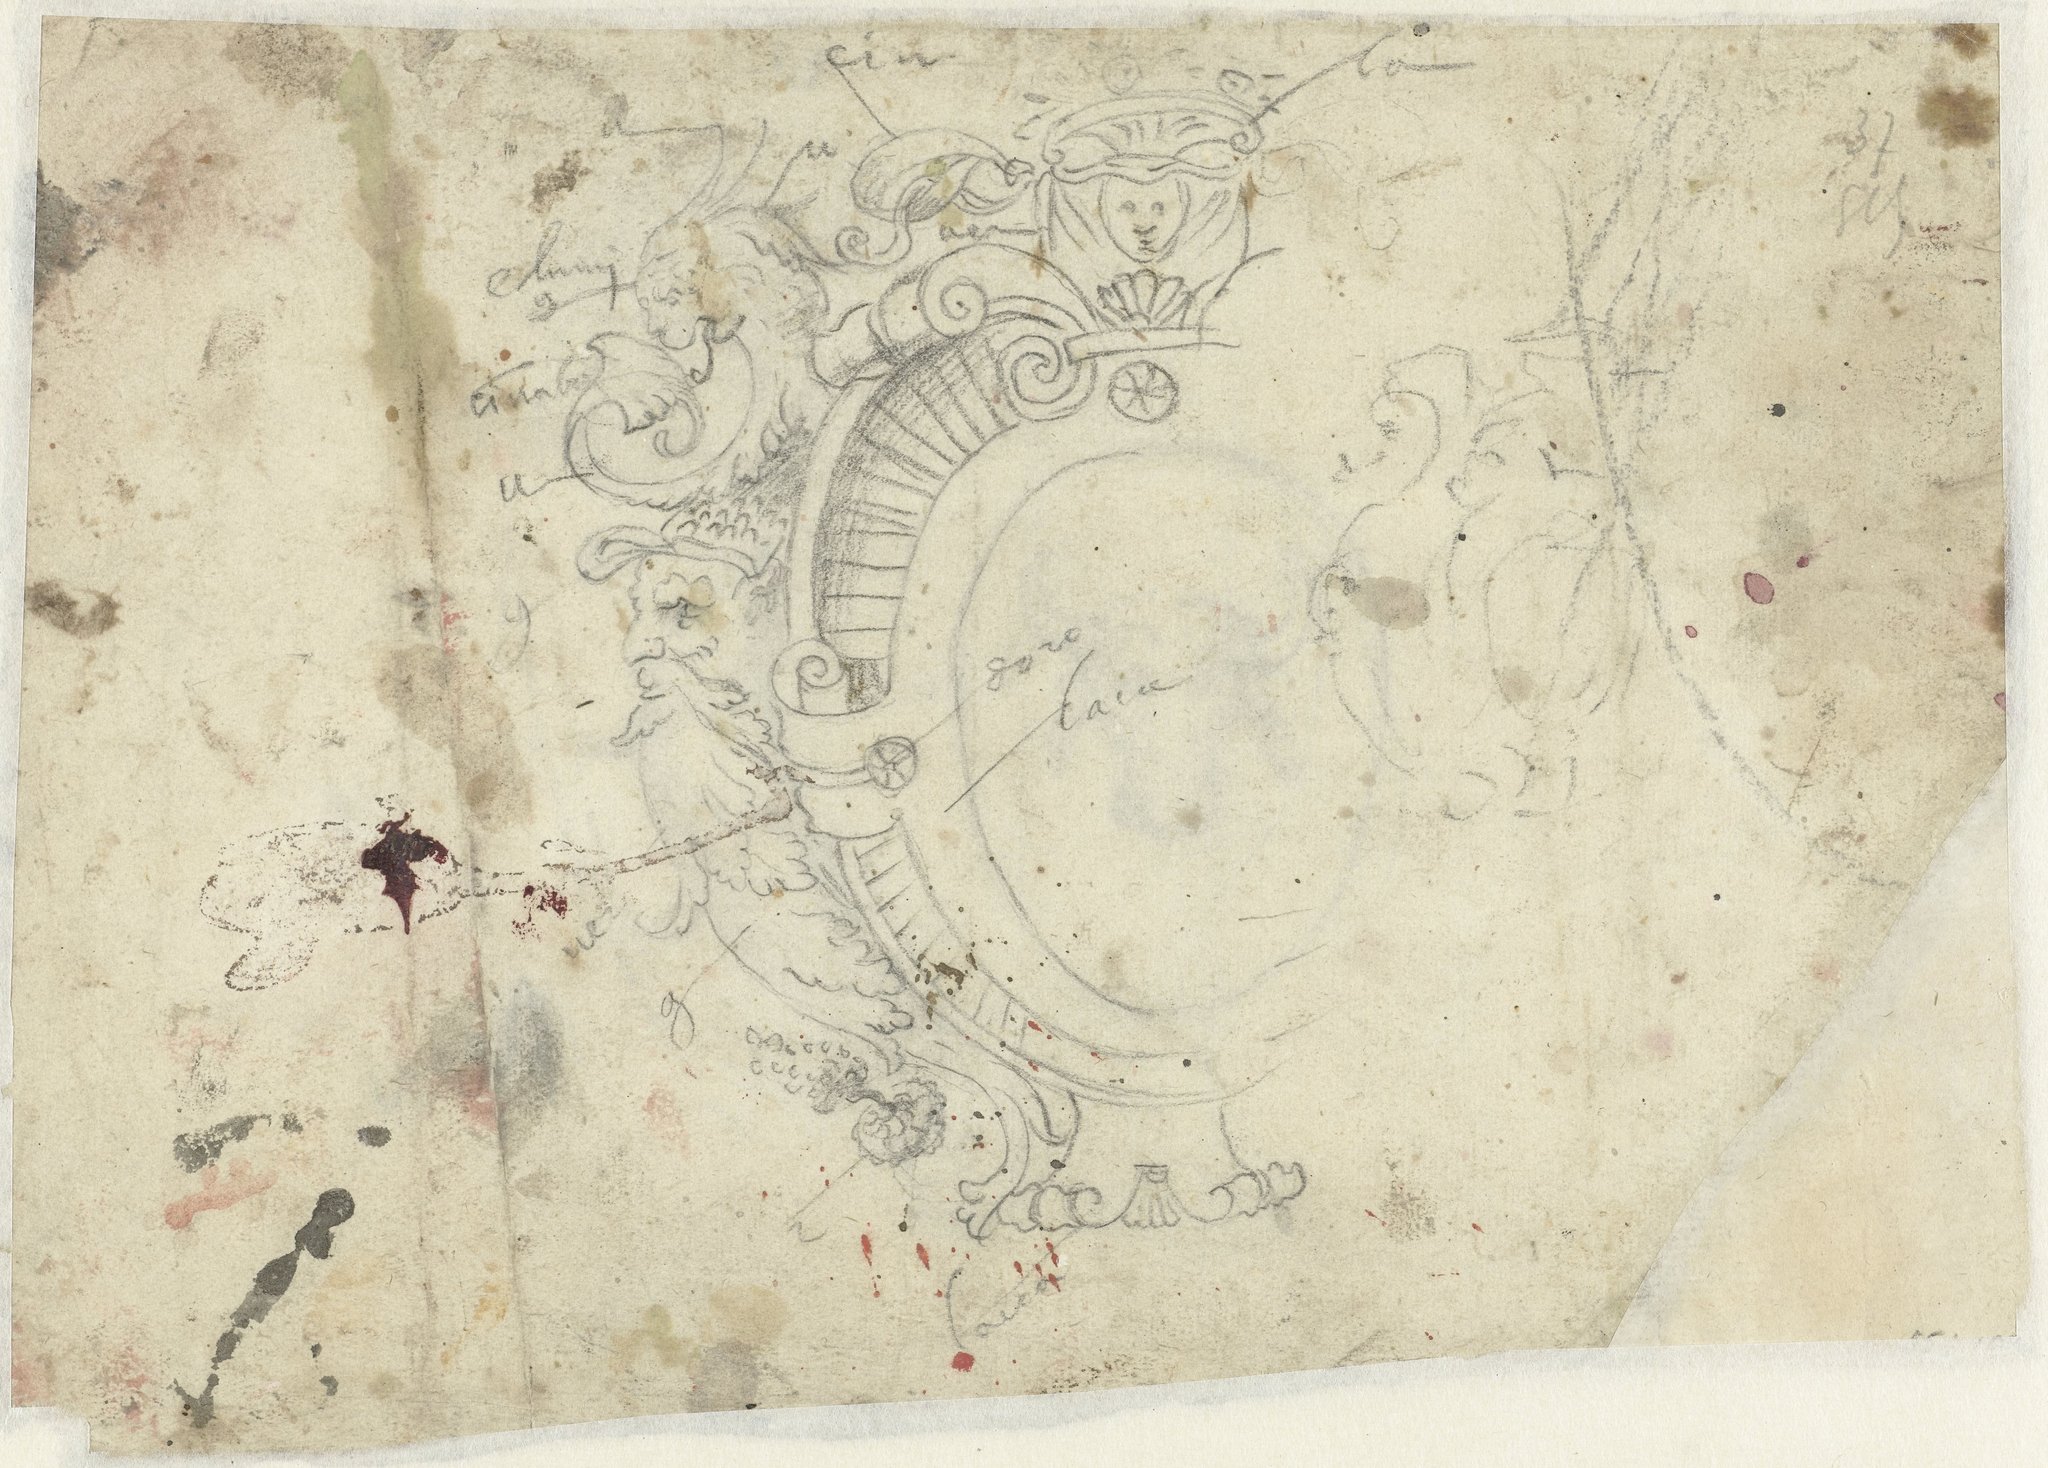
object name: drawing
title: Ontwerp voor een lijst met een familiewapen (Lenzi?)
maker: andrea di cosimo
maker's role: draughtsman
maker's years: 1477-1548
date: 1487-1548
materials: chalk, paper